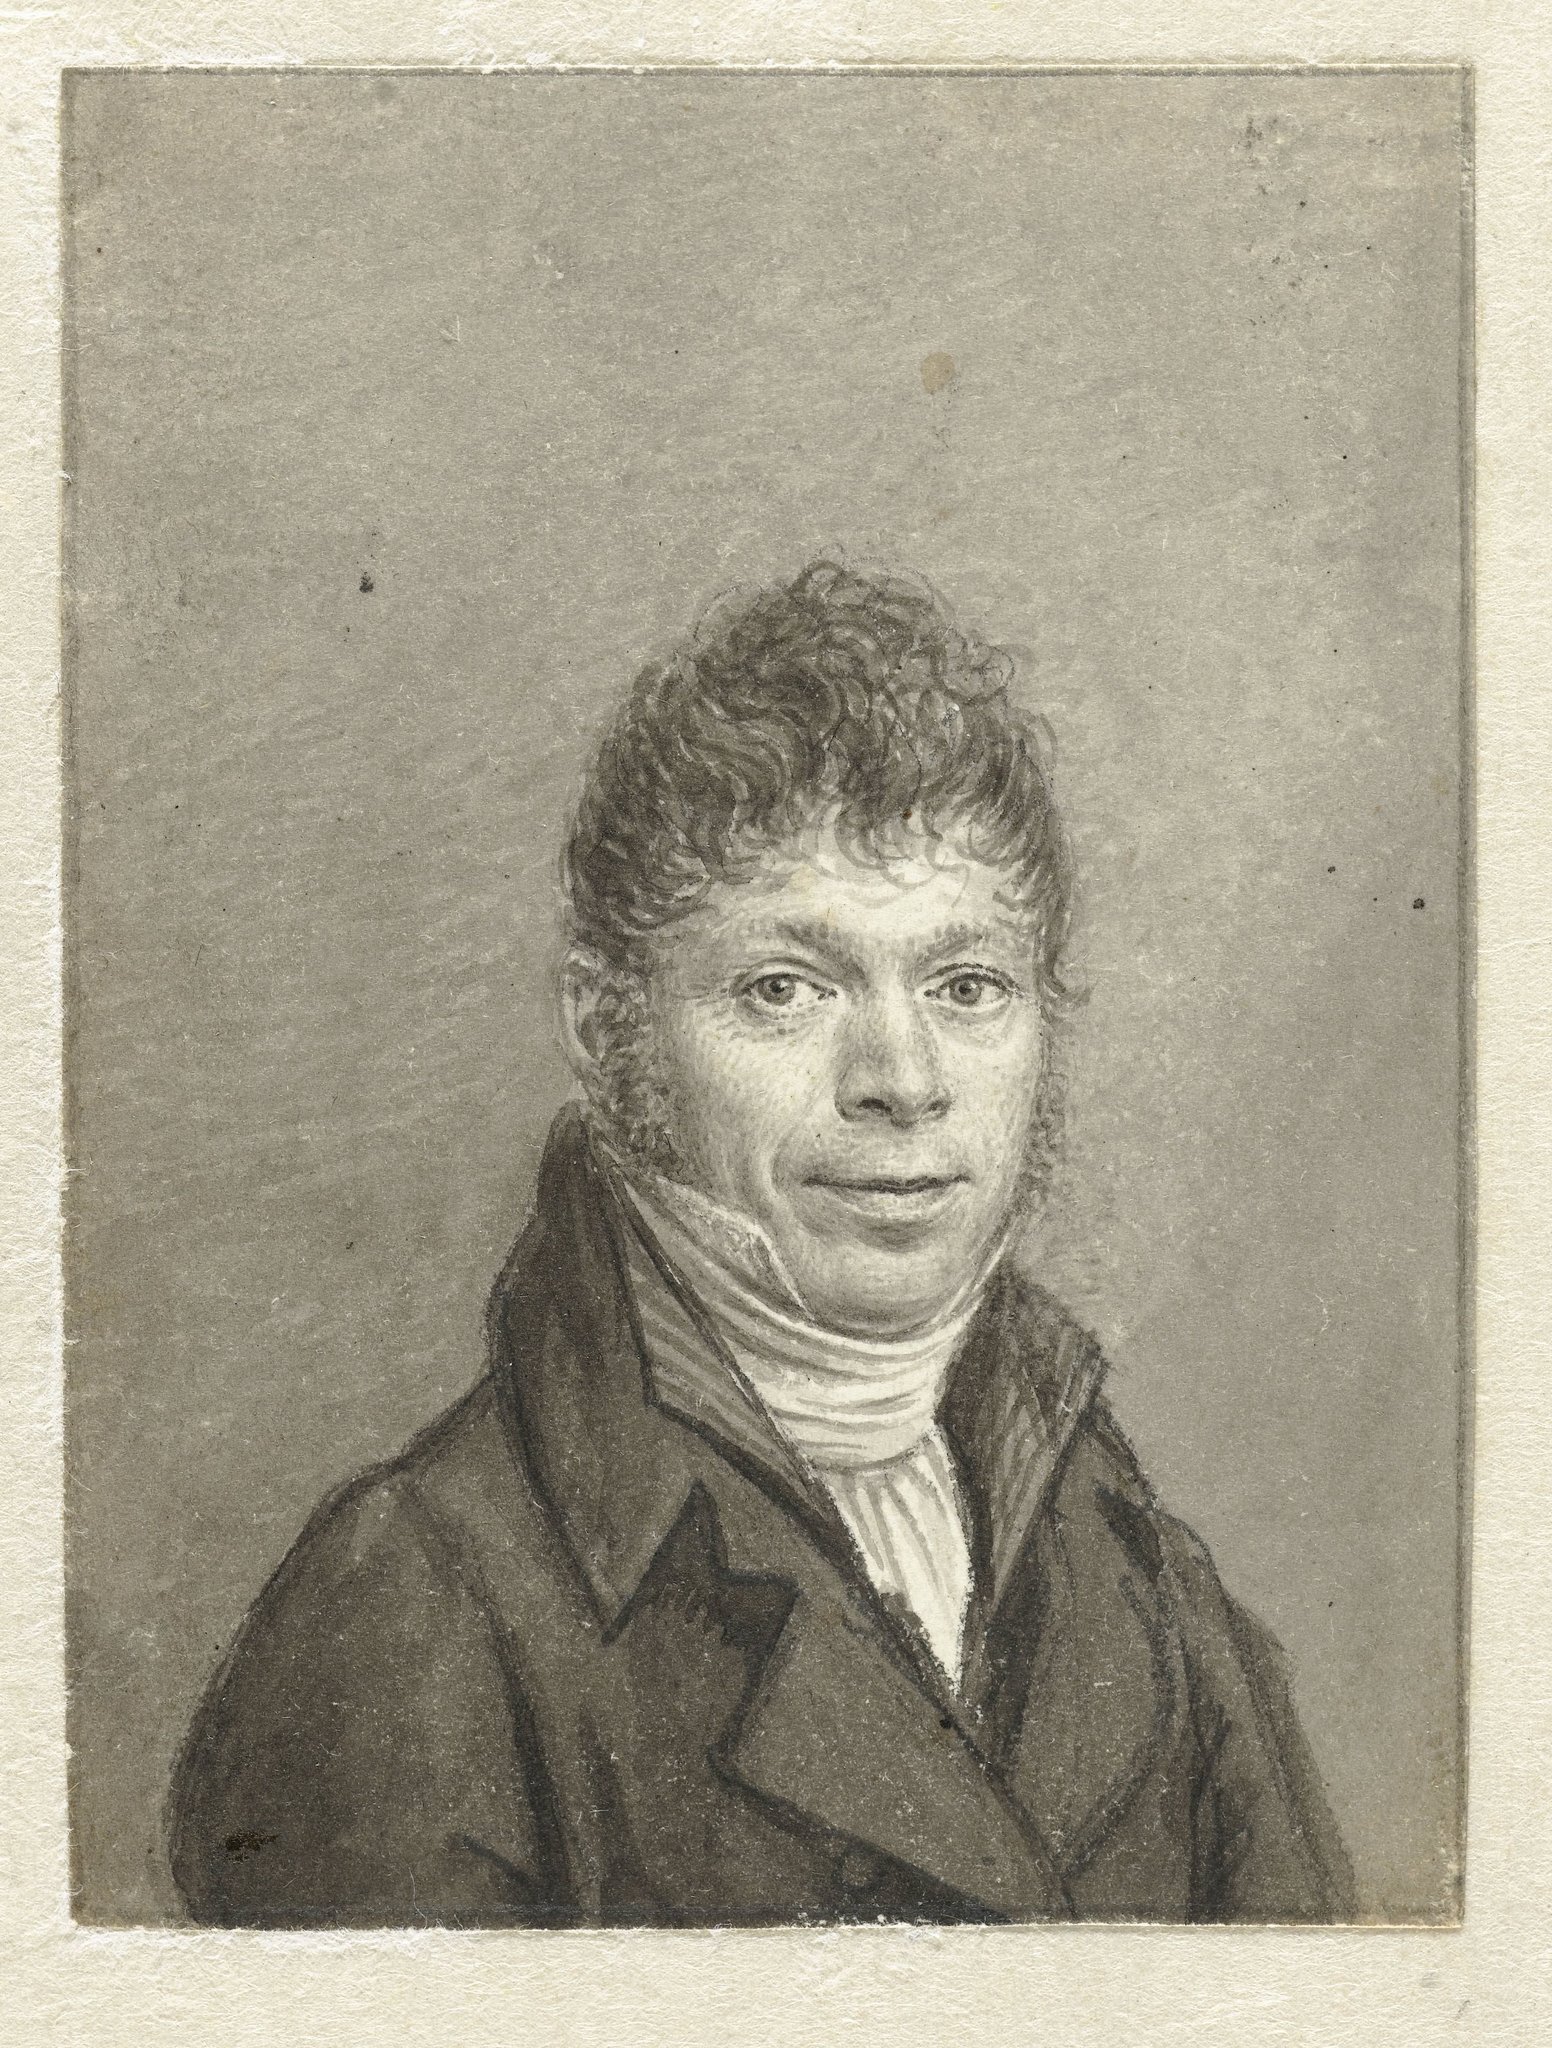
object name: drawing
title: Zelfportret van Hendrik Willem Caspari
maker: hendrik willem caspari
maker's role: draughtsman, print maker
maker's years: 1770-1829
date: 1780-1829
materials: ink, paper, pencil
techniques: brush, pen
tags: amsterdam, print maker, draughtsman, hendrik willem caspari, historical persons, portrait, self-portrait of artist, portrait, self-portrait of draughtsman